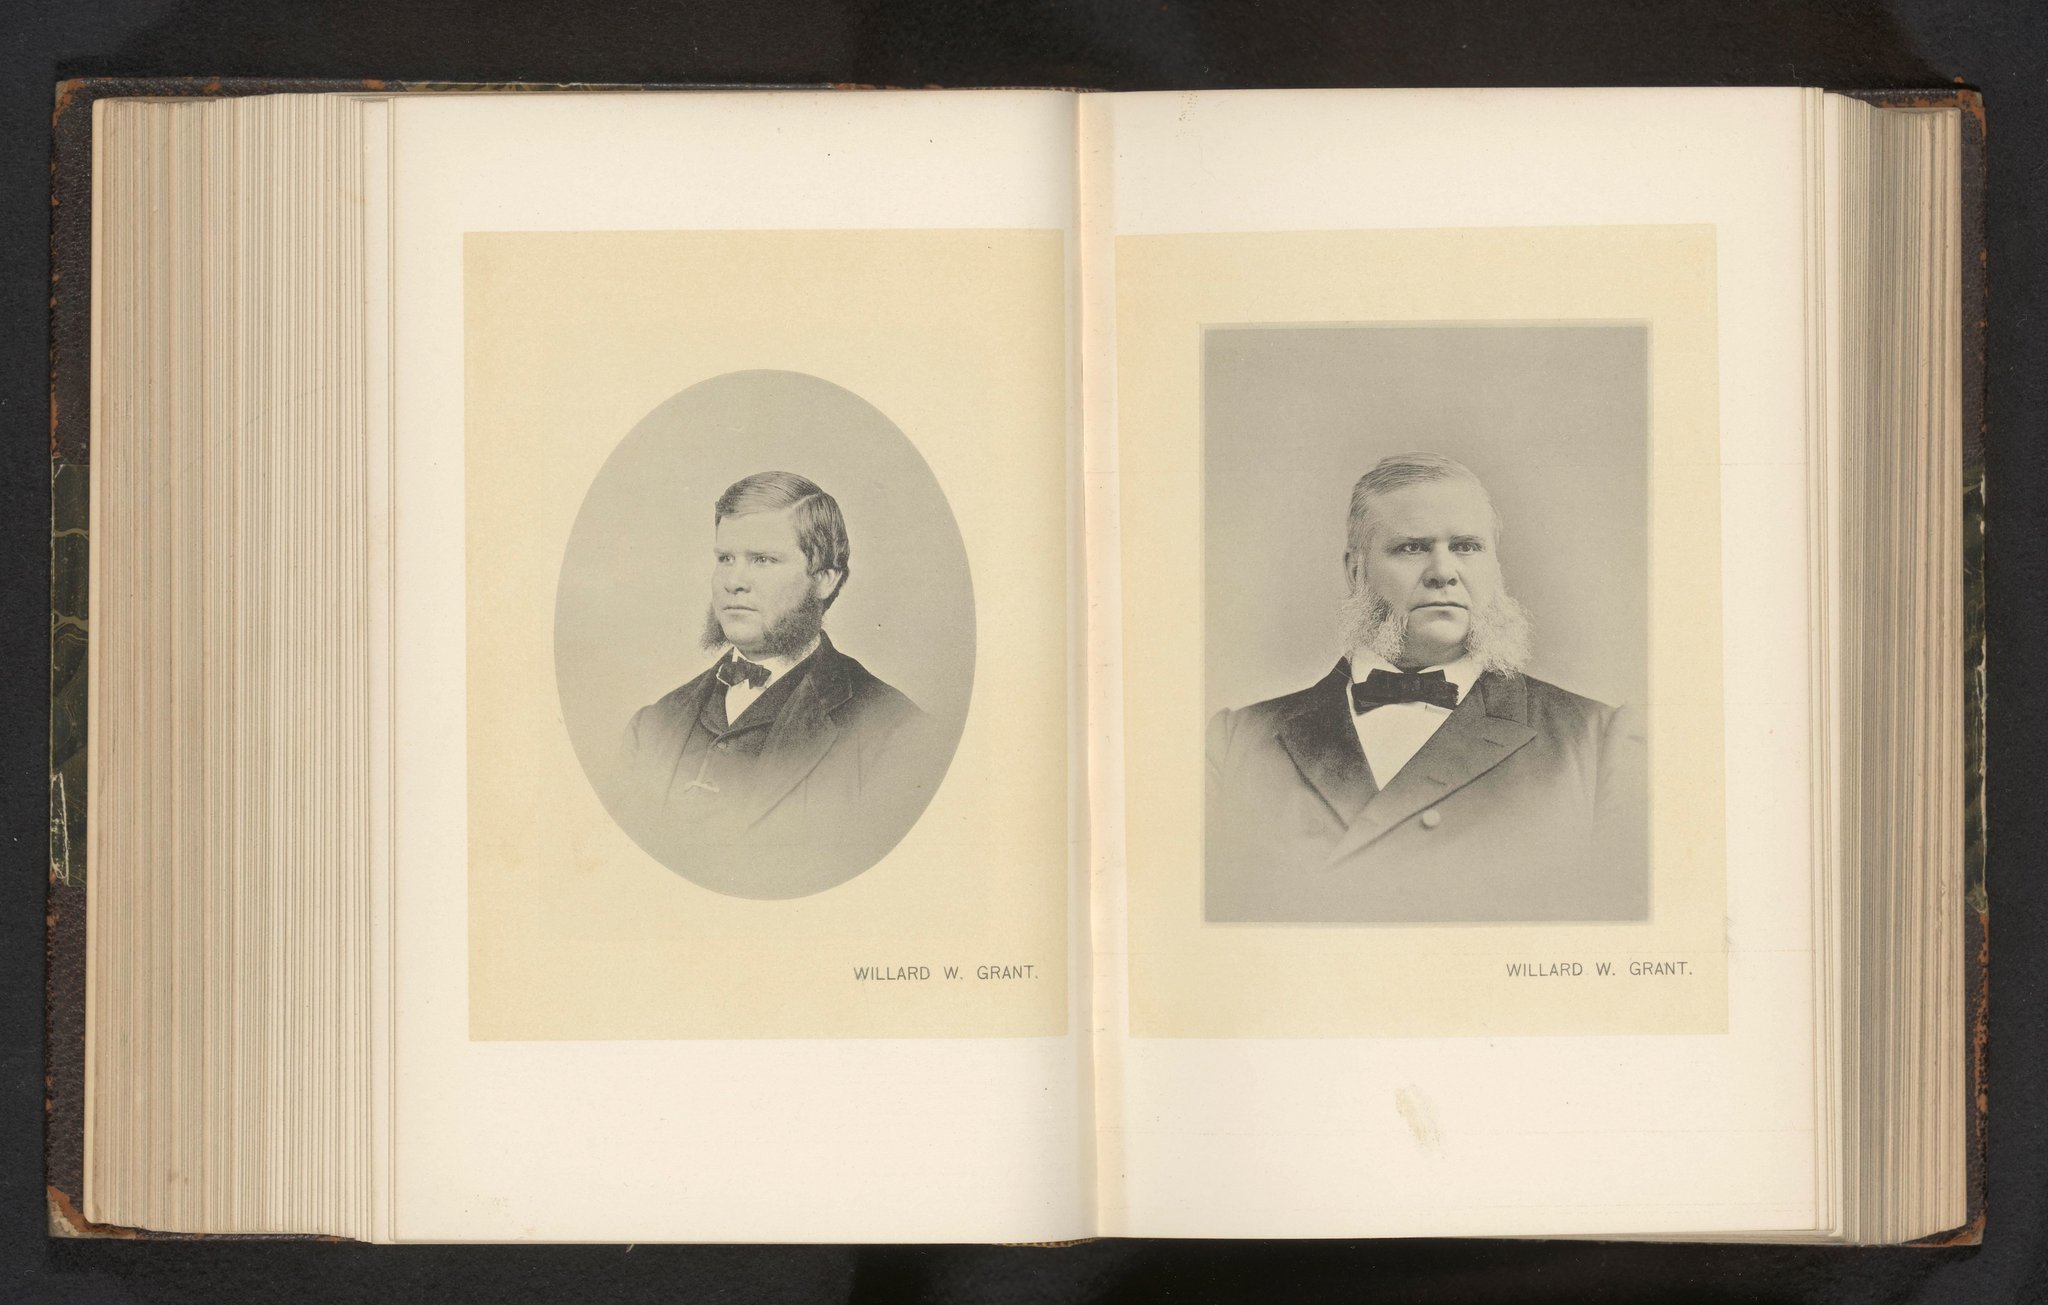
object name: page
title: Willard W. Grant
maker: Anonymous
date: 1869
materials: paper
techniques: photoaquatint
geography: boston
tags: adult man